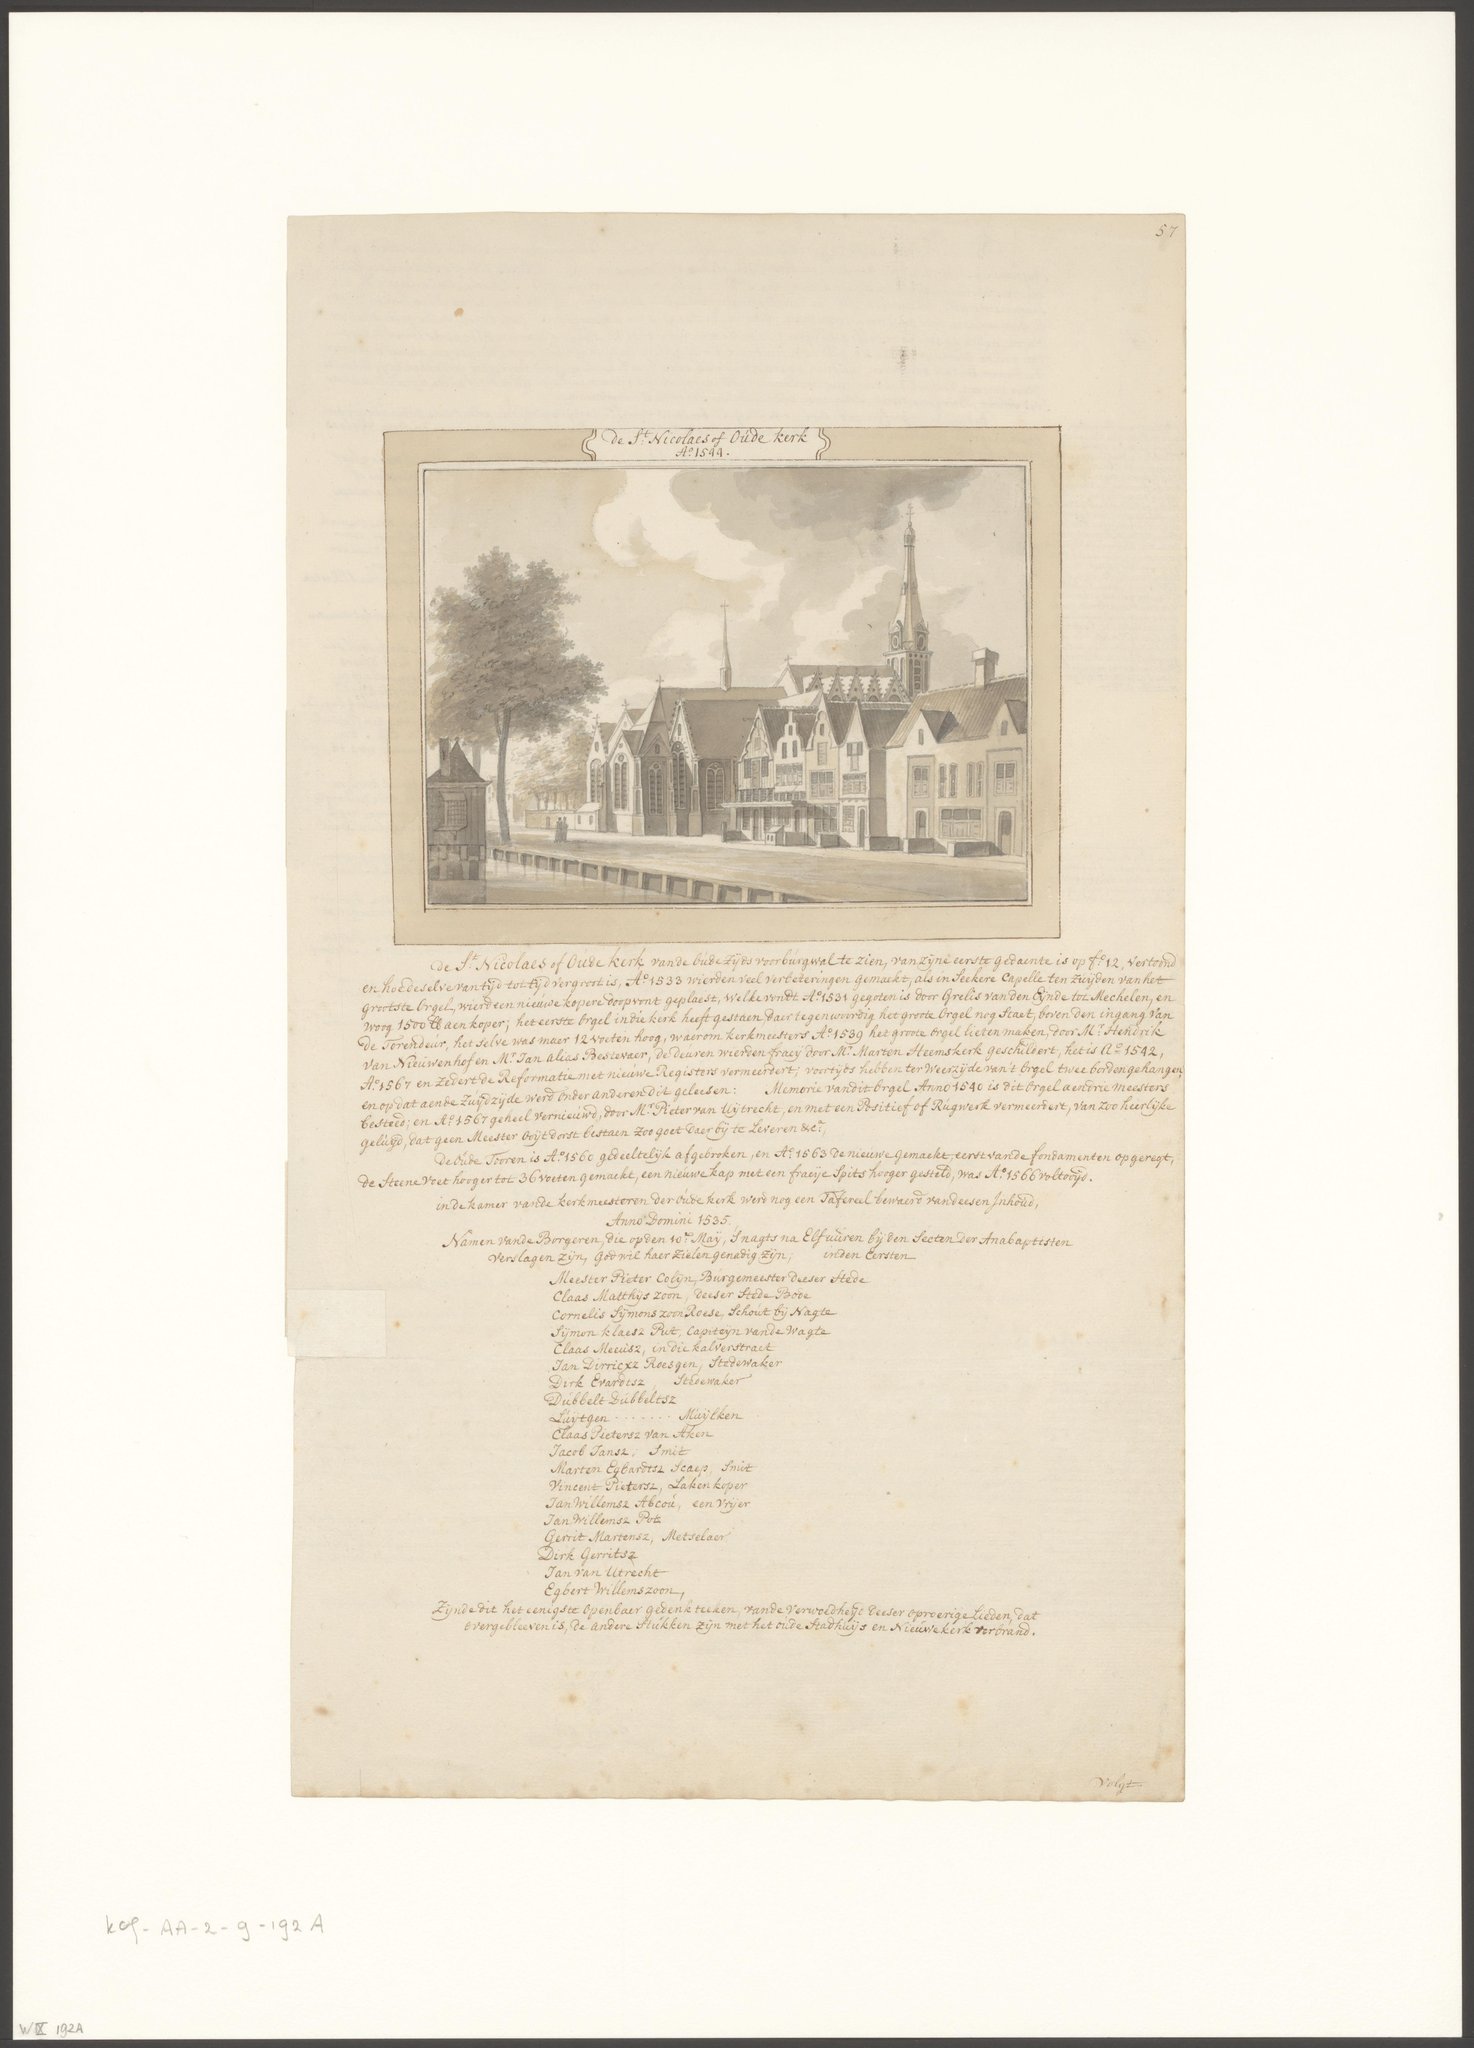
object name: drawing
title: Gezicht op de Oude Kerk met aantekeningen over een korte geschiedenis van de kerk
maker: Anonymous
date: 1700-1799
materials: ink, paper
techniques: brush, pen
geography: amsterdam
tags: city-view in general; 'veduta', canal, church (exterior)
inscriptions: inscription: ‘de St: Nicolaes of Oude Kerk / Ao 1544.’, inscription: ‘de St: Nicolaes (...) Nieuwe kerk verbrand.’, inscription: ‘Verhael van de (...) vervolgt op [...] 500’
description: Tekening binnen de Atlas Van Eck ingedeeld op wijknummer 9.